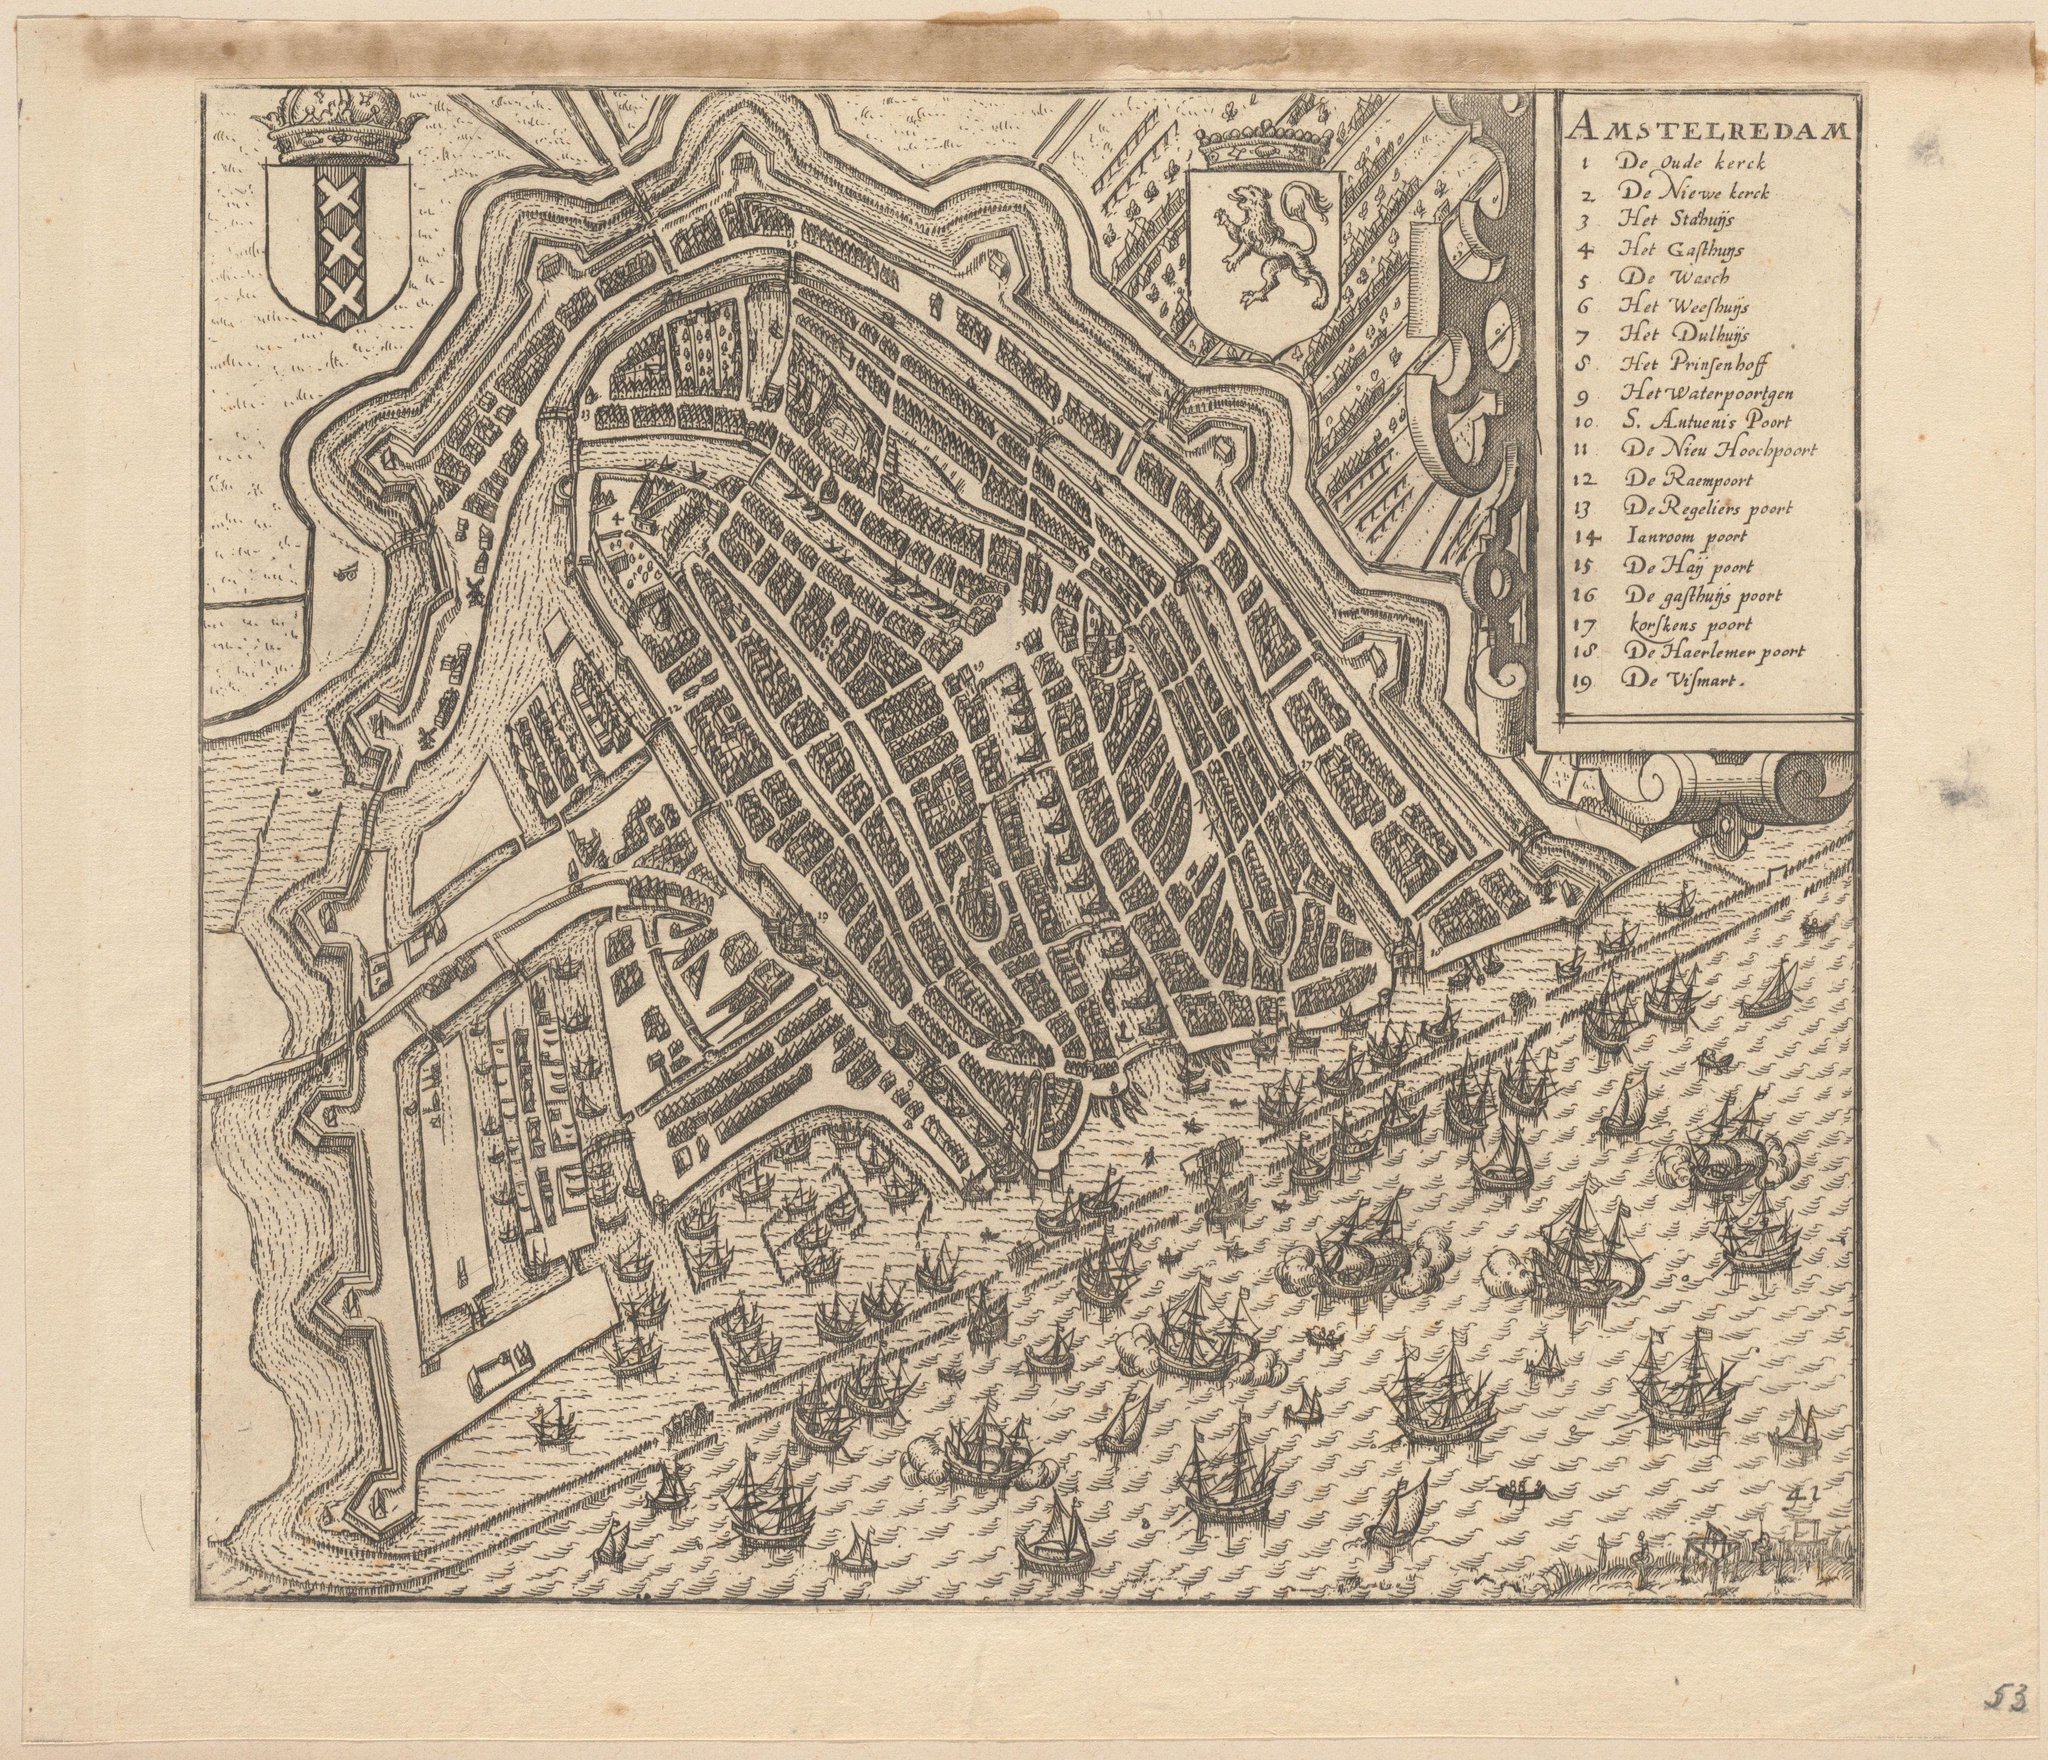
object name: map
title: Amstelredam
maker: Anonymous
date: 1612-1648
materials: paper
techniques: engraving, etching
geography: northern netherlands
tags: coat of arms (as symbol of the state, etc.) (+ city; municipal), maps of cities, coat of arms (as symbol of the state, etc.) (+ province; provincial), amsterdam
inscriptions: collector's mark: Lugt 1641b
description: Prent mogelijk uit: Guicciardini, Lodovico. Beschryvinghe van alle de Nederlanden, anderssins ghenoemt Neder-Duytslandt. Amsterdam: Willem Janszoon Blaeu, 1612. Of uit latere edities (en vertalingen) van 1613, 1624, 1625, 1646 en 1648, uitgegeven door Willem Janszoon Blaeu en Johannes Janssonius.